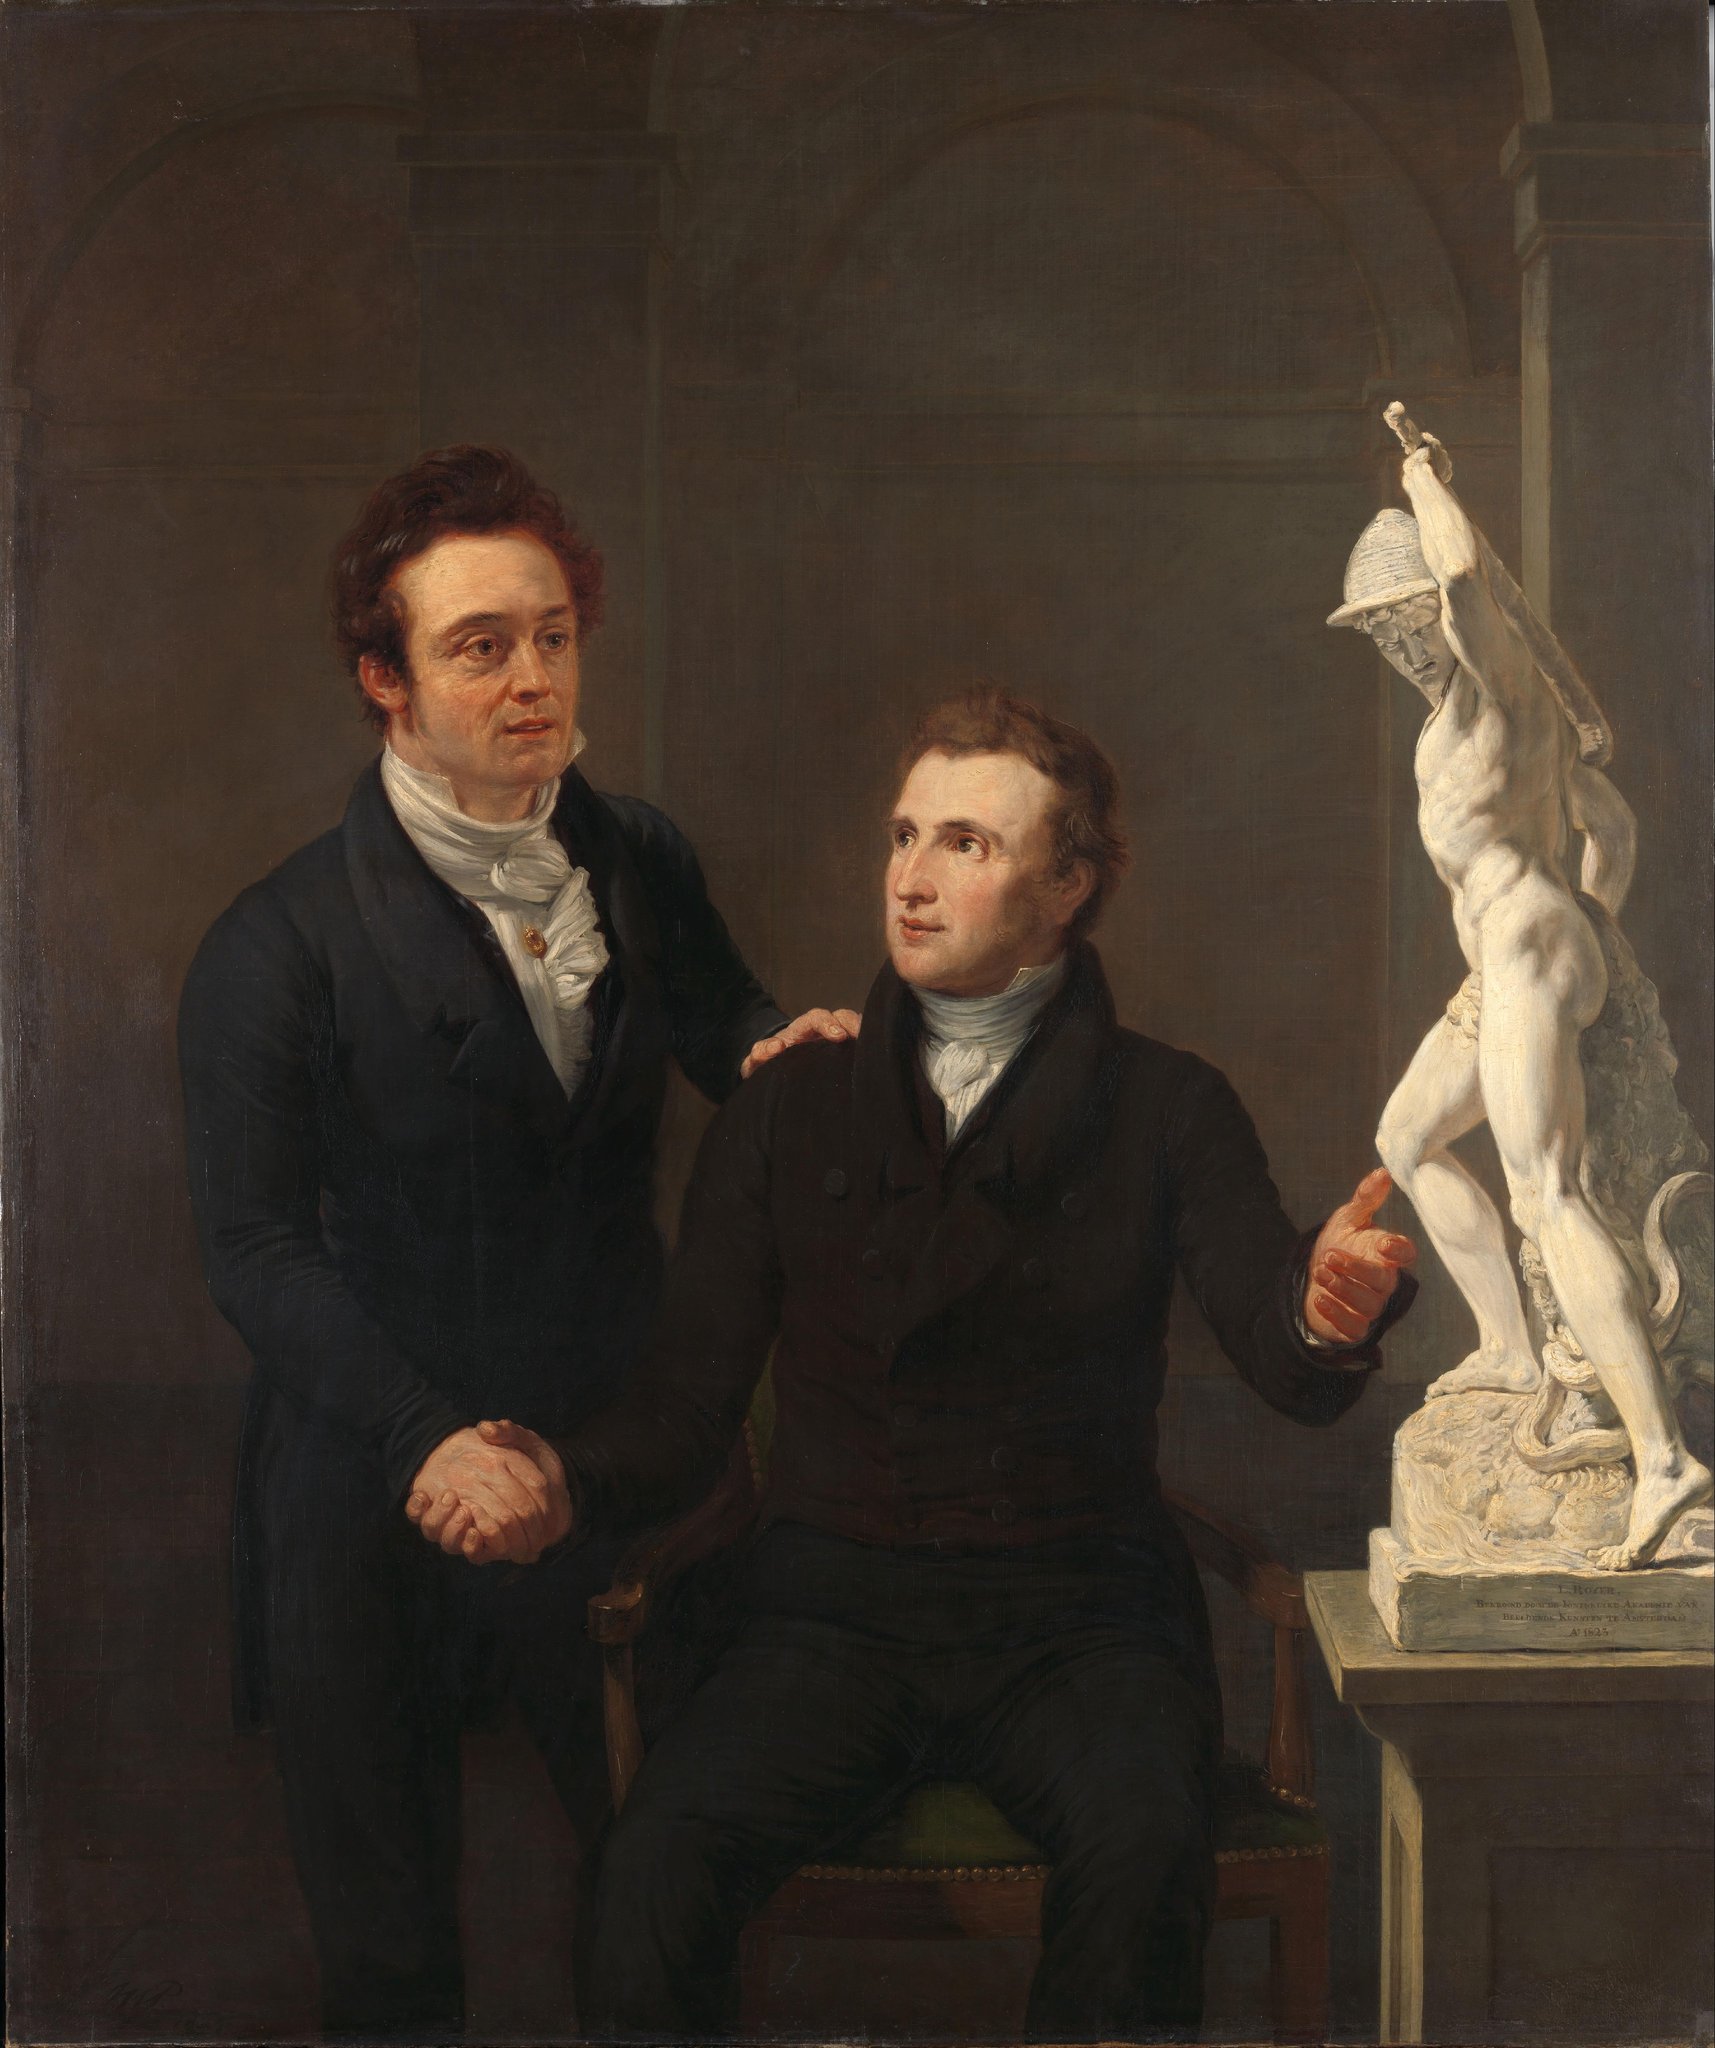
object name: painting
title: Louis Royer, Sculptor, and Albertus Bernardus Roothaan, Stockbroker, Friend of the Arts, and Patron of the Sciences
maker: jan willem pieneman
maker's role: draughtsman, painter, print maker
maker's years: 1779-1853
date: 1825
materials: canvas, oil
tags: mechelen, amsterdam, draughtsman, sculptor, louis royer, portrait, self-portrait of sculptor, historical persons, piece of sculpture, reproduction of a piece of sculpture, portrait, self-portrait of artist, person stimulating the arts; art lover, connoisseur, maecenas, patron, brussels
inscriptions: signature and date: ‘J.W.P. fecit 1825’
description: Portretten van Louis Royer (1787-1868), beeldhouwer en Albertus Bernardus Roothaan (1793-1847), makelaar in effecten, kunstvriend en bevorderaar der wetenschappen. De twee mannen geven elkaar de hand, rechts op een tafel staat het beeld van Royer van een Griekse herder die een slang verslaat.